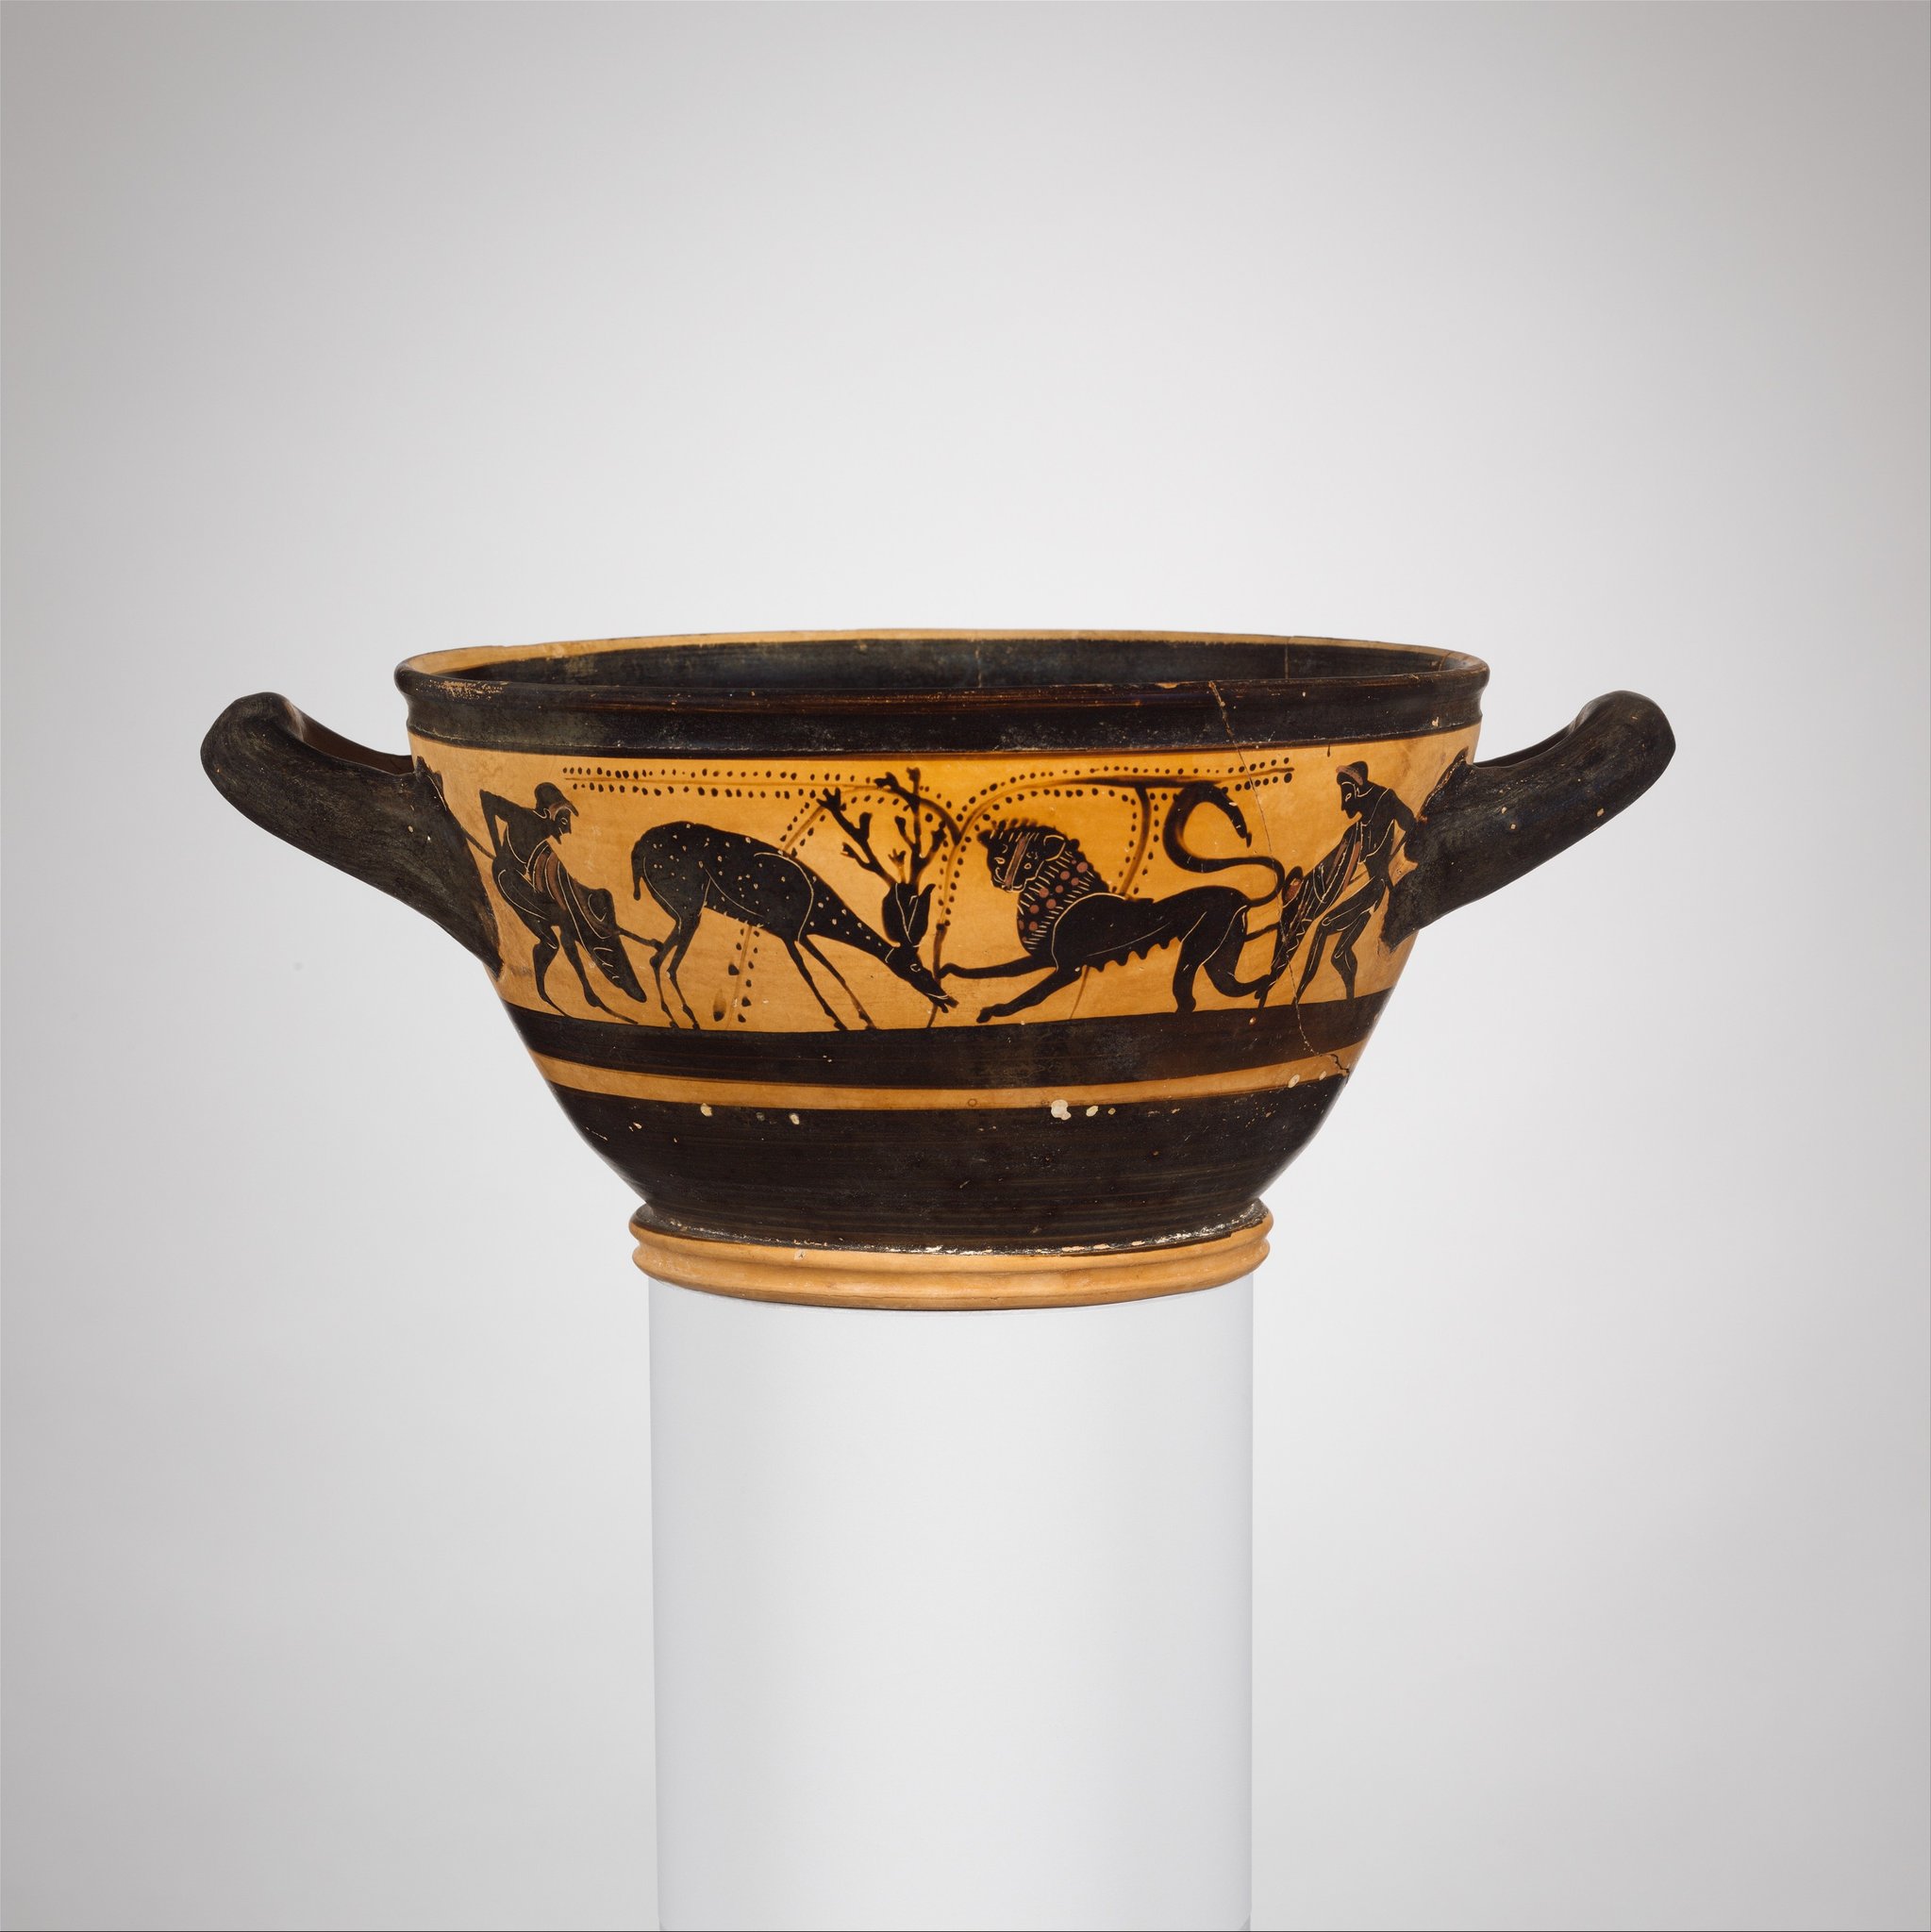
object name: skyphos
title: Terracotta skyphos (deep drinking cup)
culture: greek, attic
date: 500 BCE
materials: terracotta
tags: deer,lions